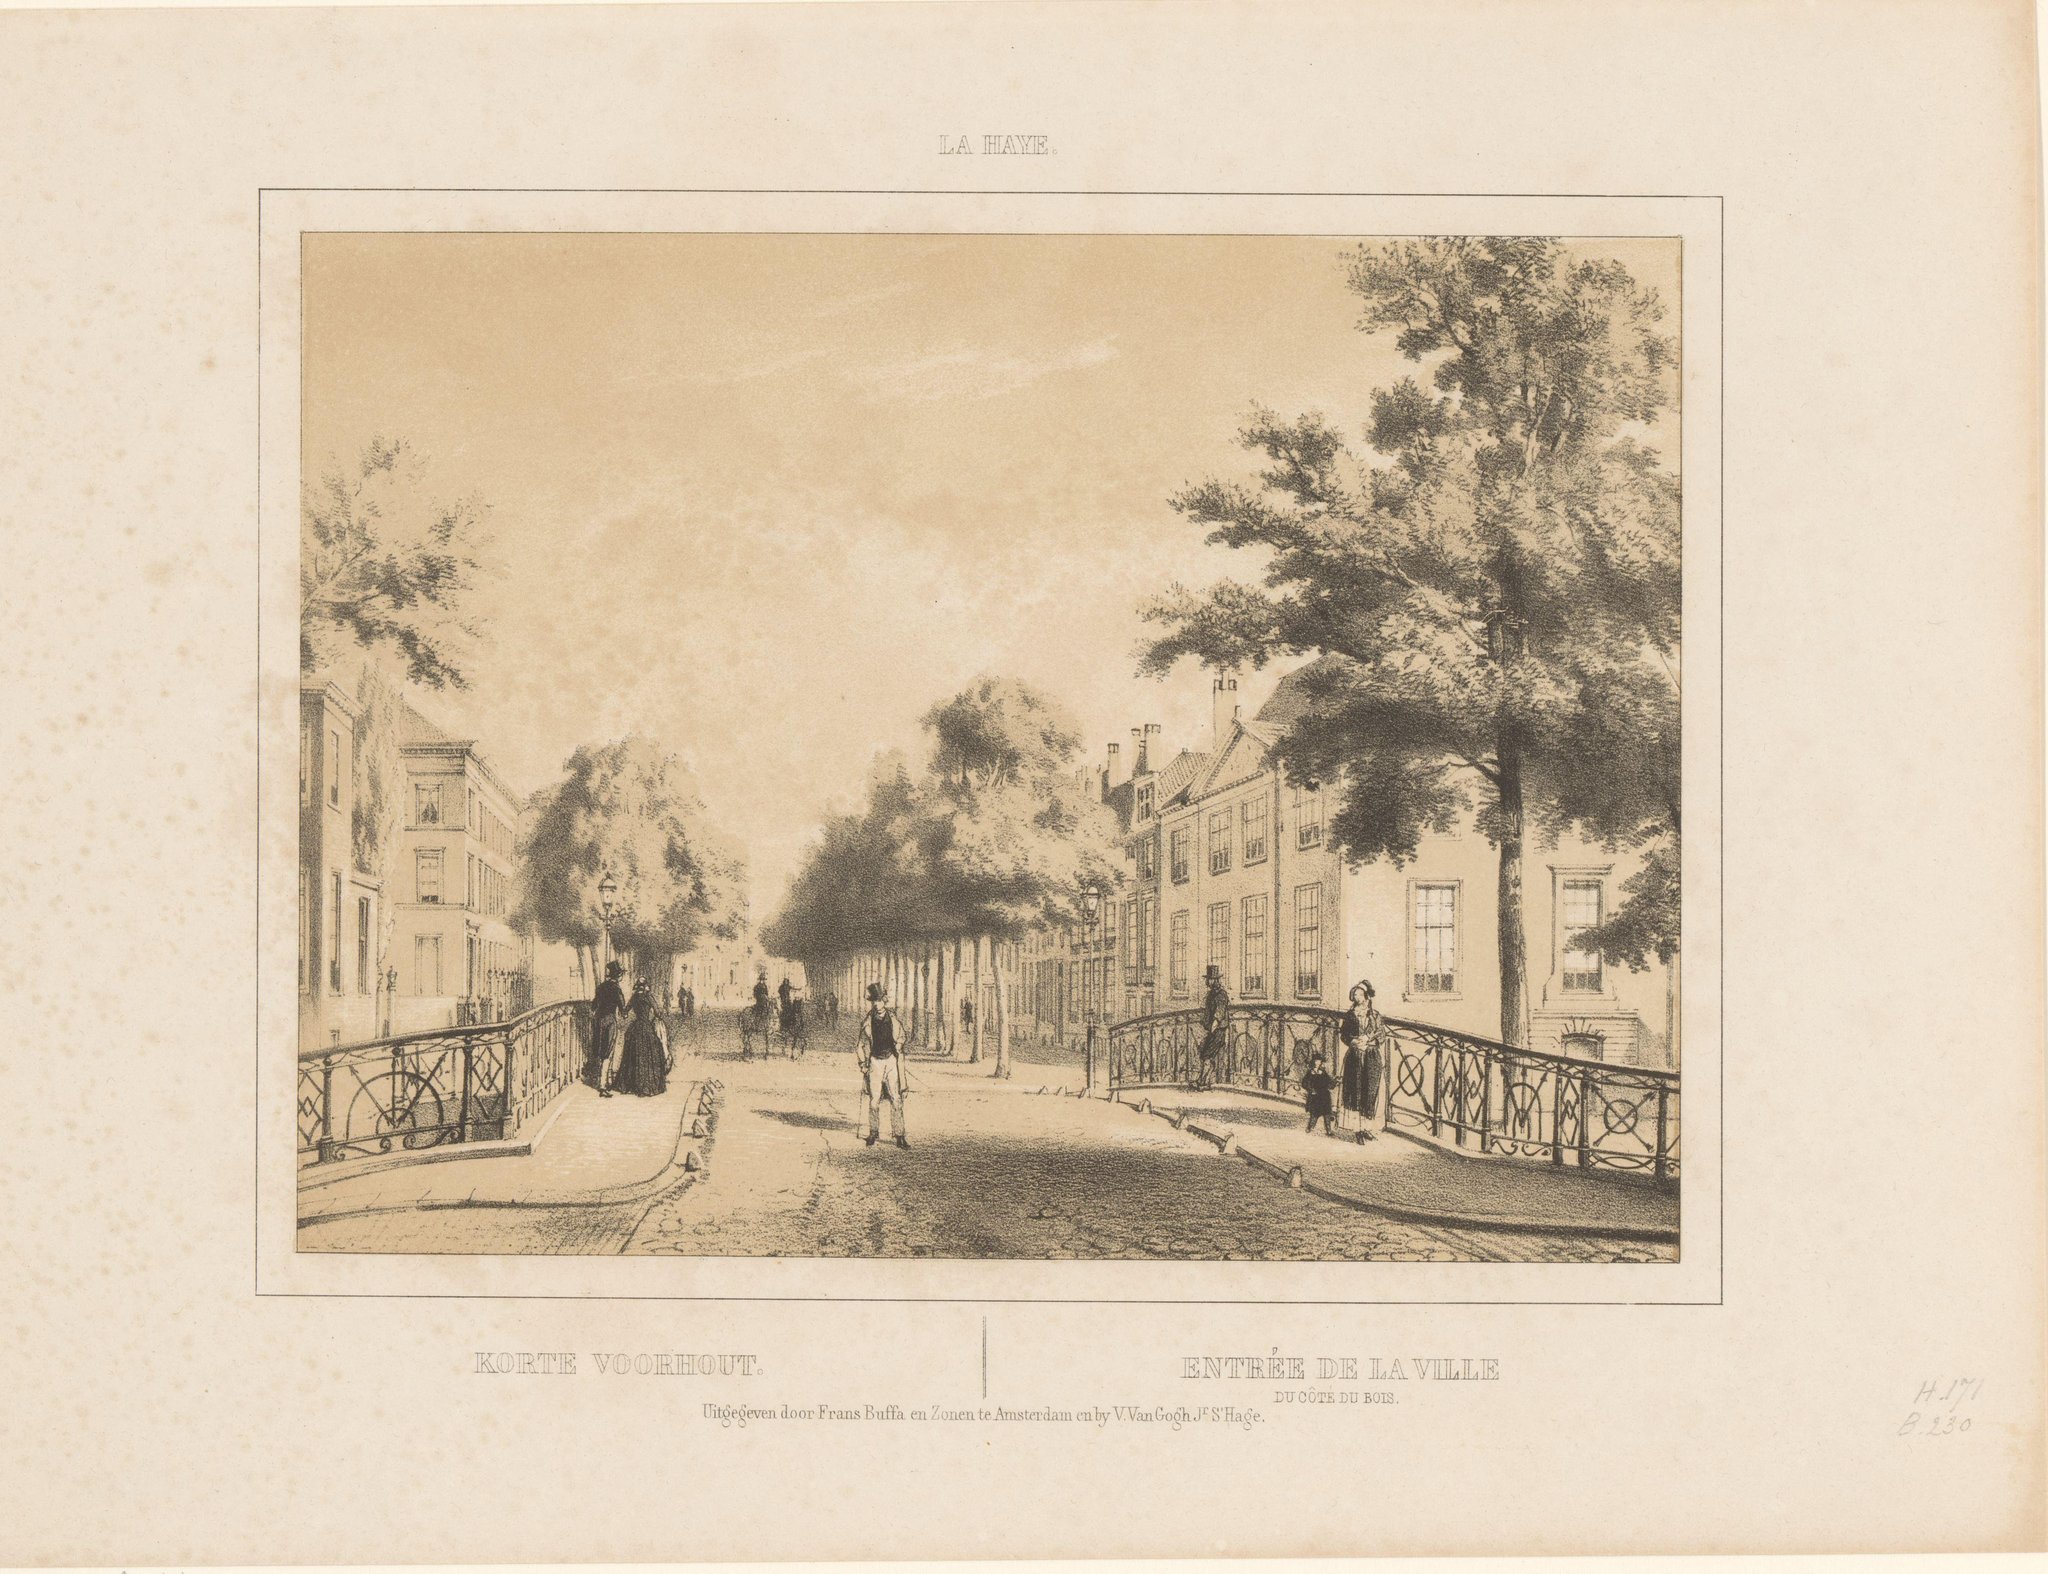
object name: print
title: Gezicht op het Korte Voorhout te Den Haag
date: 1832-1880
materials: paper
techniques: tone lithography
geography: amsterdam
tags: street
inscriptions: collector's mark: Lugt 2228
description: Mensen op de bosbrug (of koningsbrug) bij het Korte Voorhout.